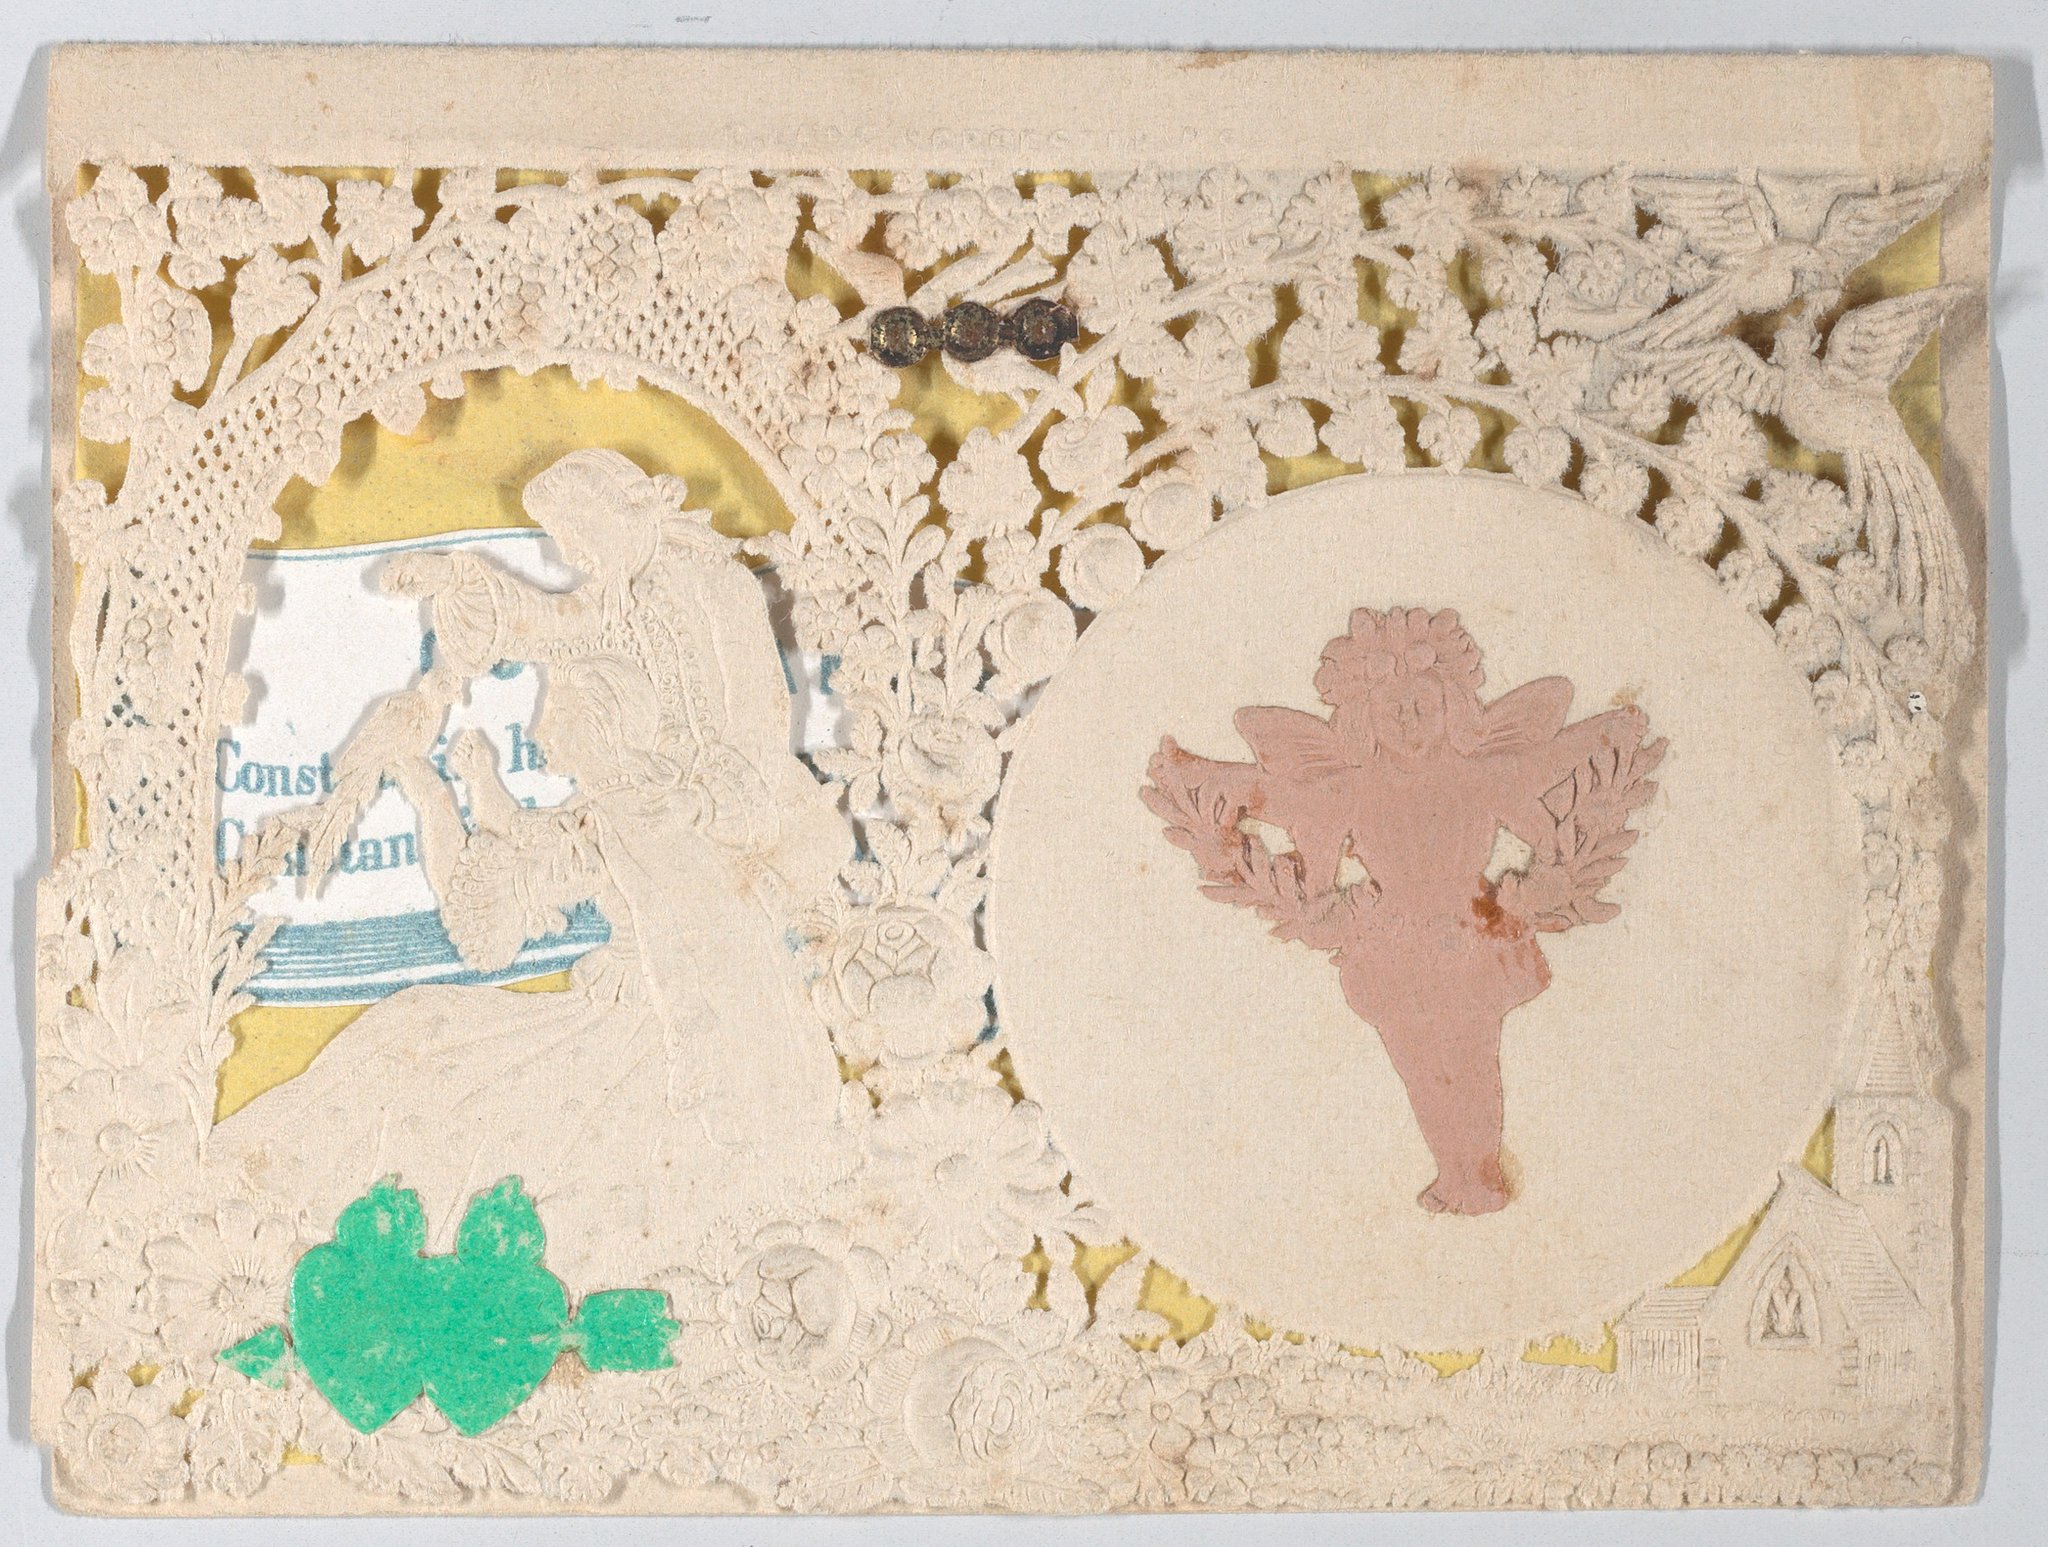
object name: valentine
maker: Anonymous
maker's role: artist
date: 1850-1870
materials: ink, lace, paper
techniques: embossing, open work